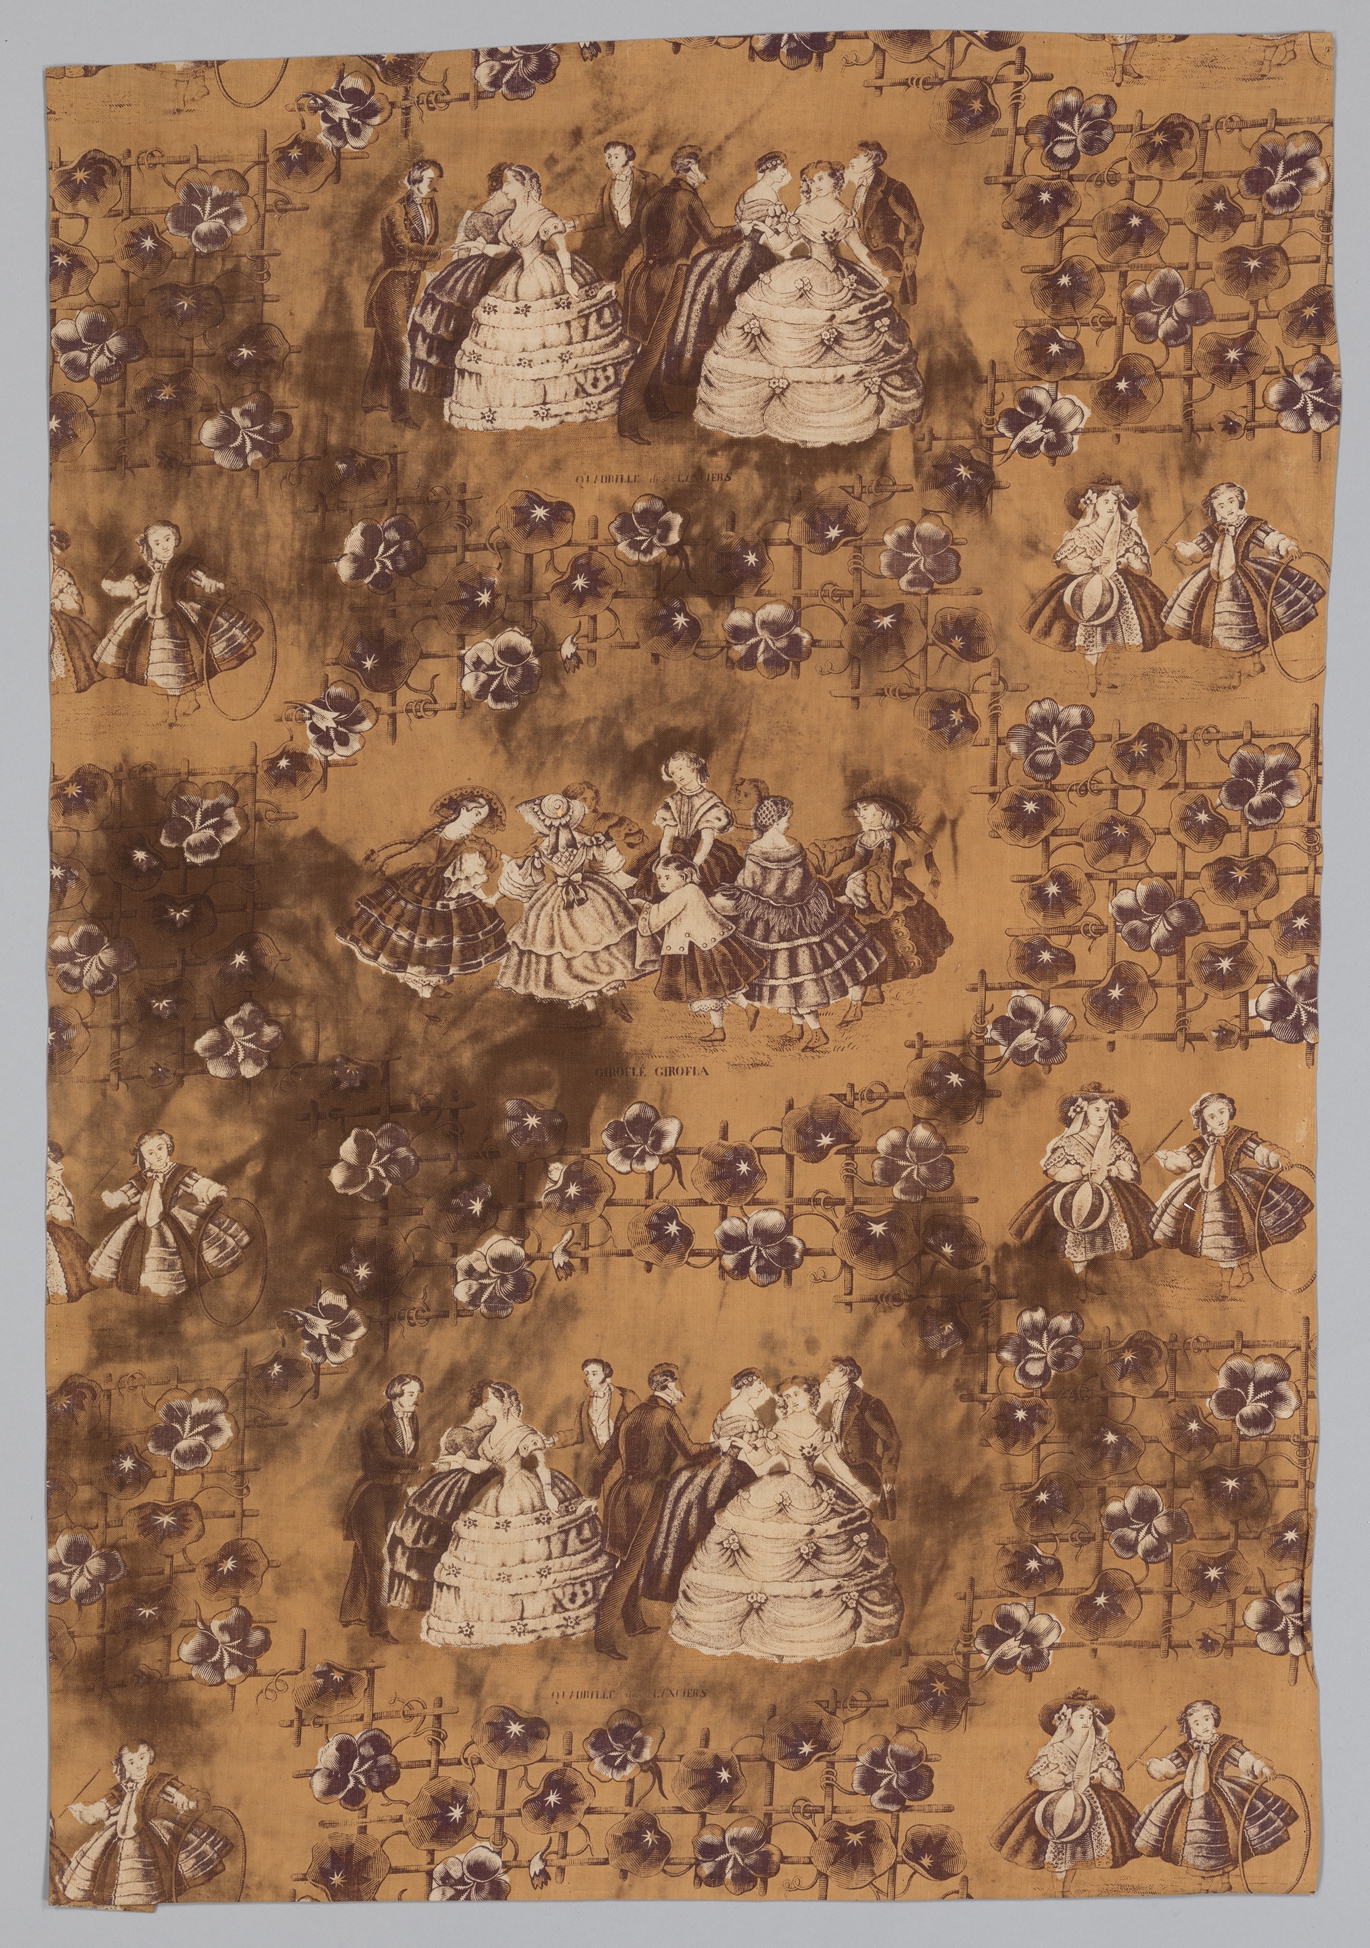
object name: furnishing textile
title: Giroflé-Giroflà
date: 1860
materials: cotton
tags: men,women,flowers